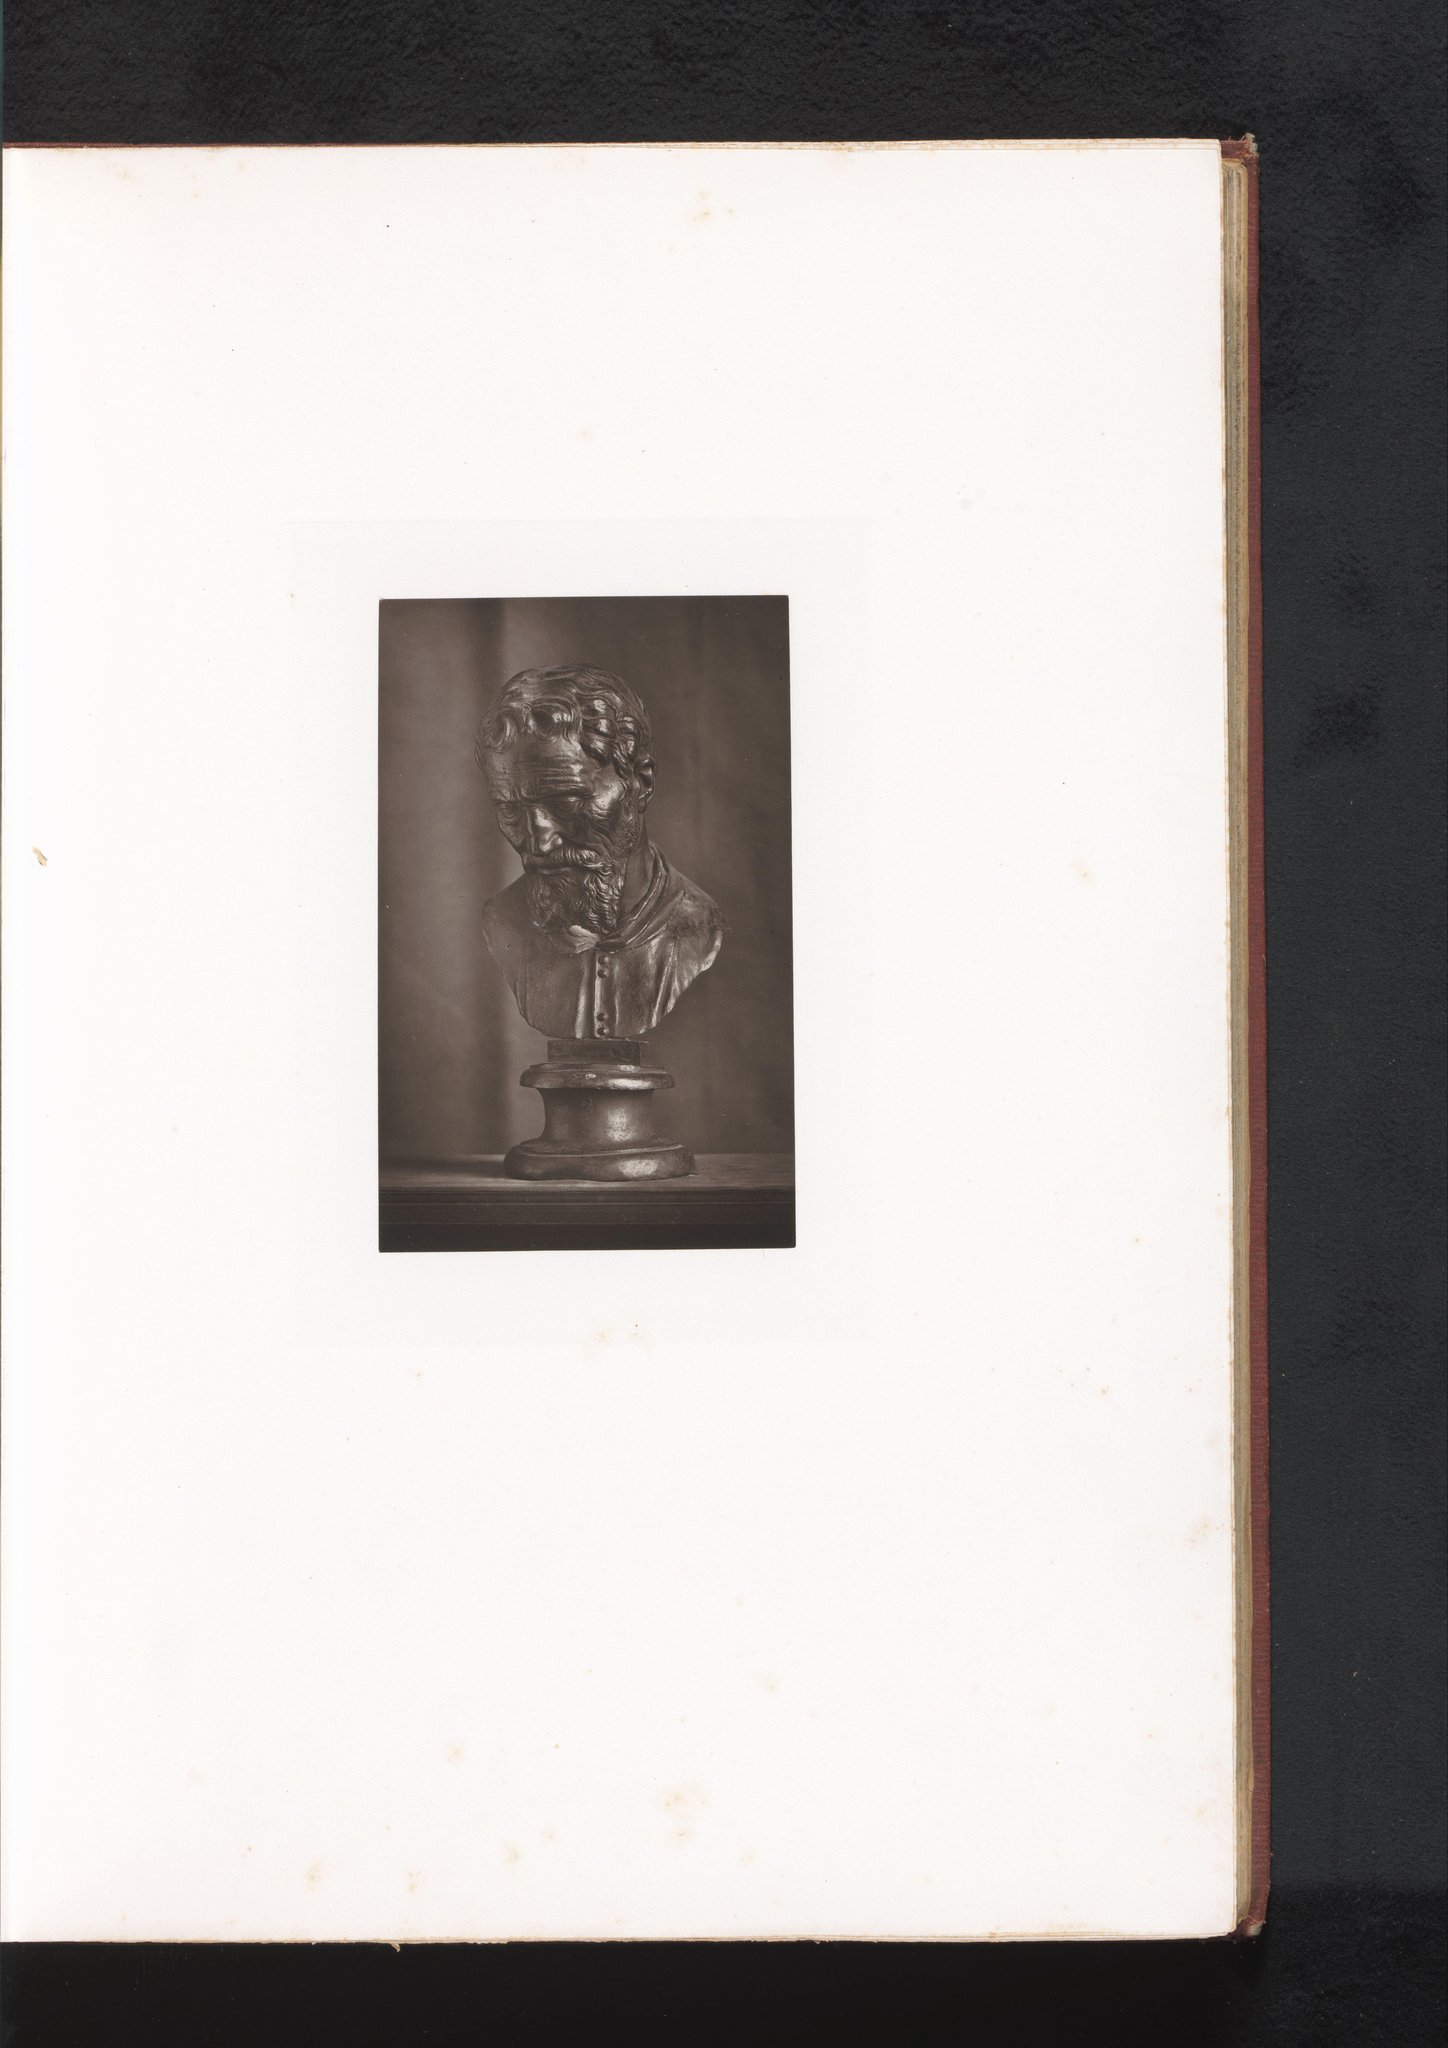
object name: page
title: Buste van Michelangelo, opgesteld tijdens de Exposition Rétrospective van 1873 in Tours, Frankrijk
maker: gabriel blaise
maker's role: printer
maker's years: 1827-1897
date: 1873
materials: paper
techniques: woodburytype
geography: tours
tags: rome, painter, draughtsman, sculptor, michelangelo, piece of sculpture, reproduction of a piece of sculpture, temporary exhibition, 'salon'